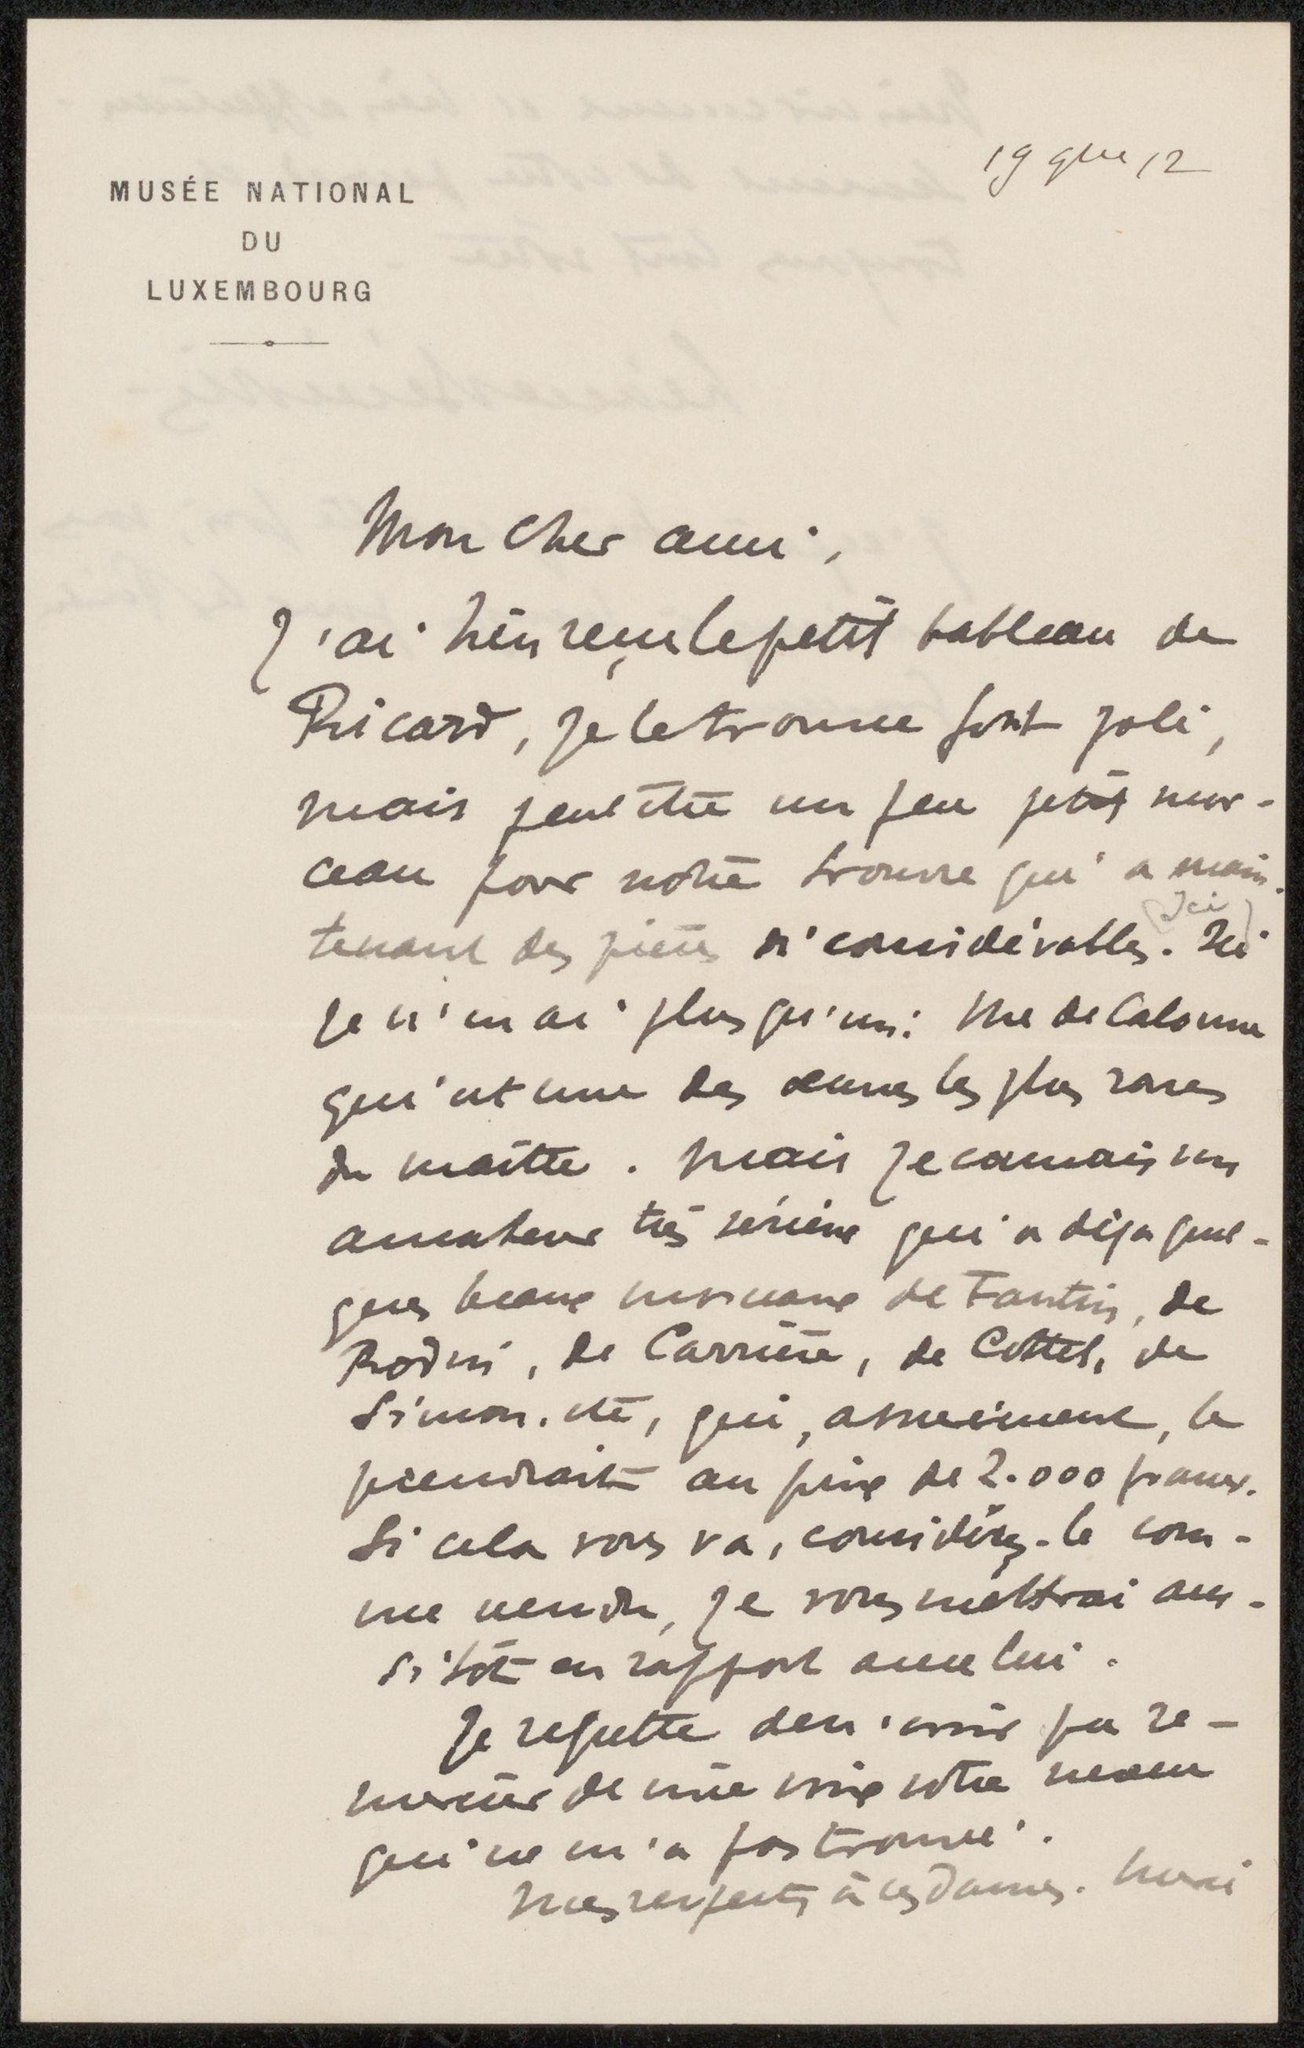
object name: letter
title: Brief aan Philip Zilcken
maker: léonce bénédite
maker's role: conservator, museumdirecteur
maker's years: 1856-1925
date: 1912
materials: ink, paper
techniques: pen, printing, writing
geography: paris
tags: the hague, painter, philip zilcken, painting (including book-illumination, miniature-painting)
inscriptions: collector's mark: ‘RPK’